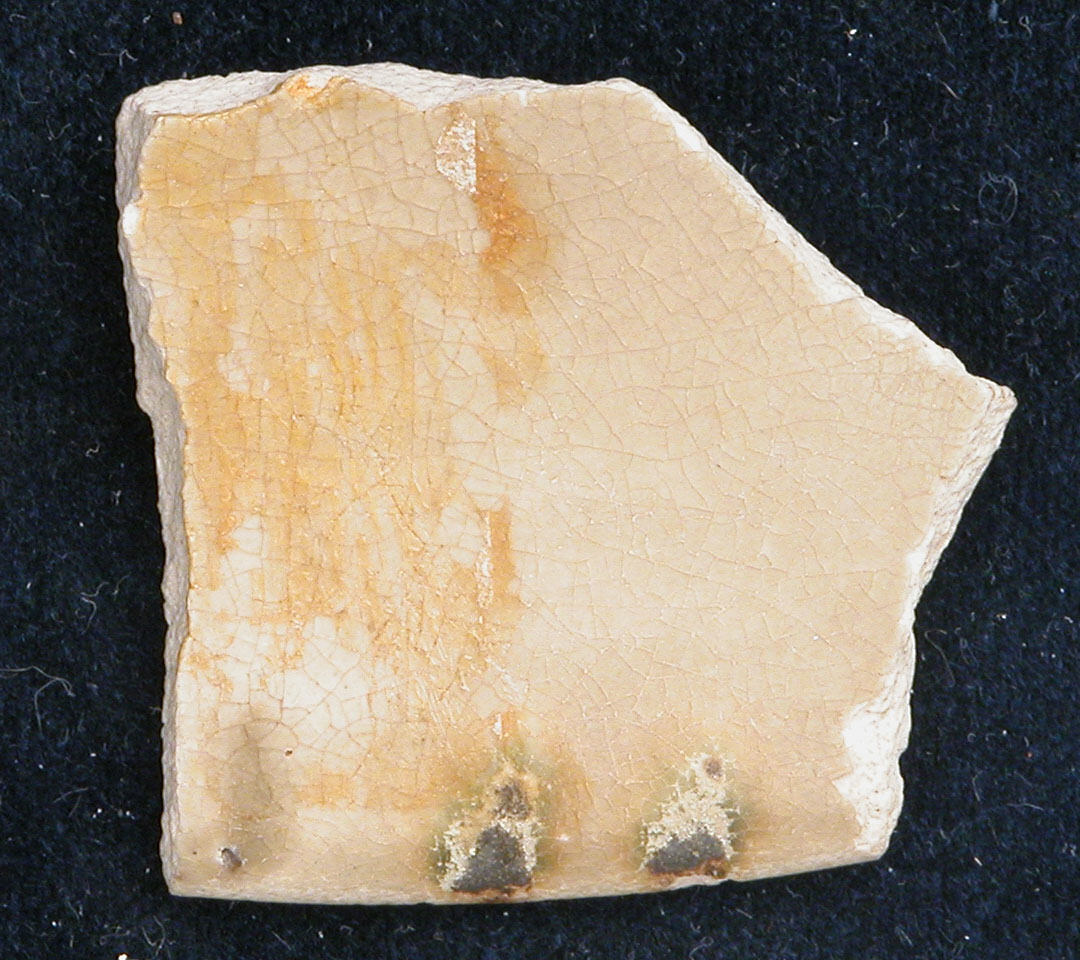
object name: fragment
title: Ceramic Fragment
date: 1101-1300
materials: stonepaste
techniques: glazing, painting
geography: saudi arabia